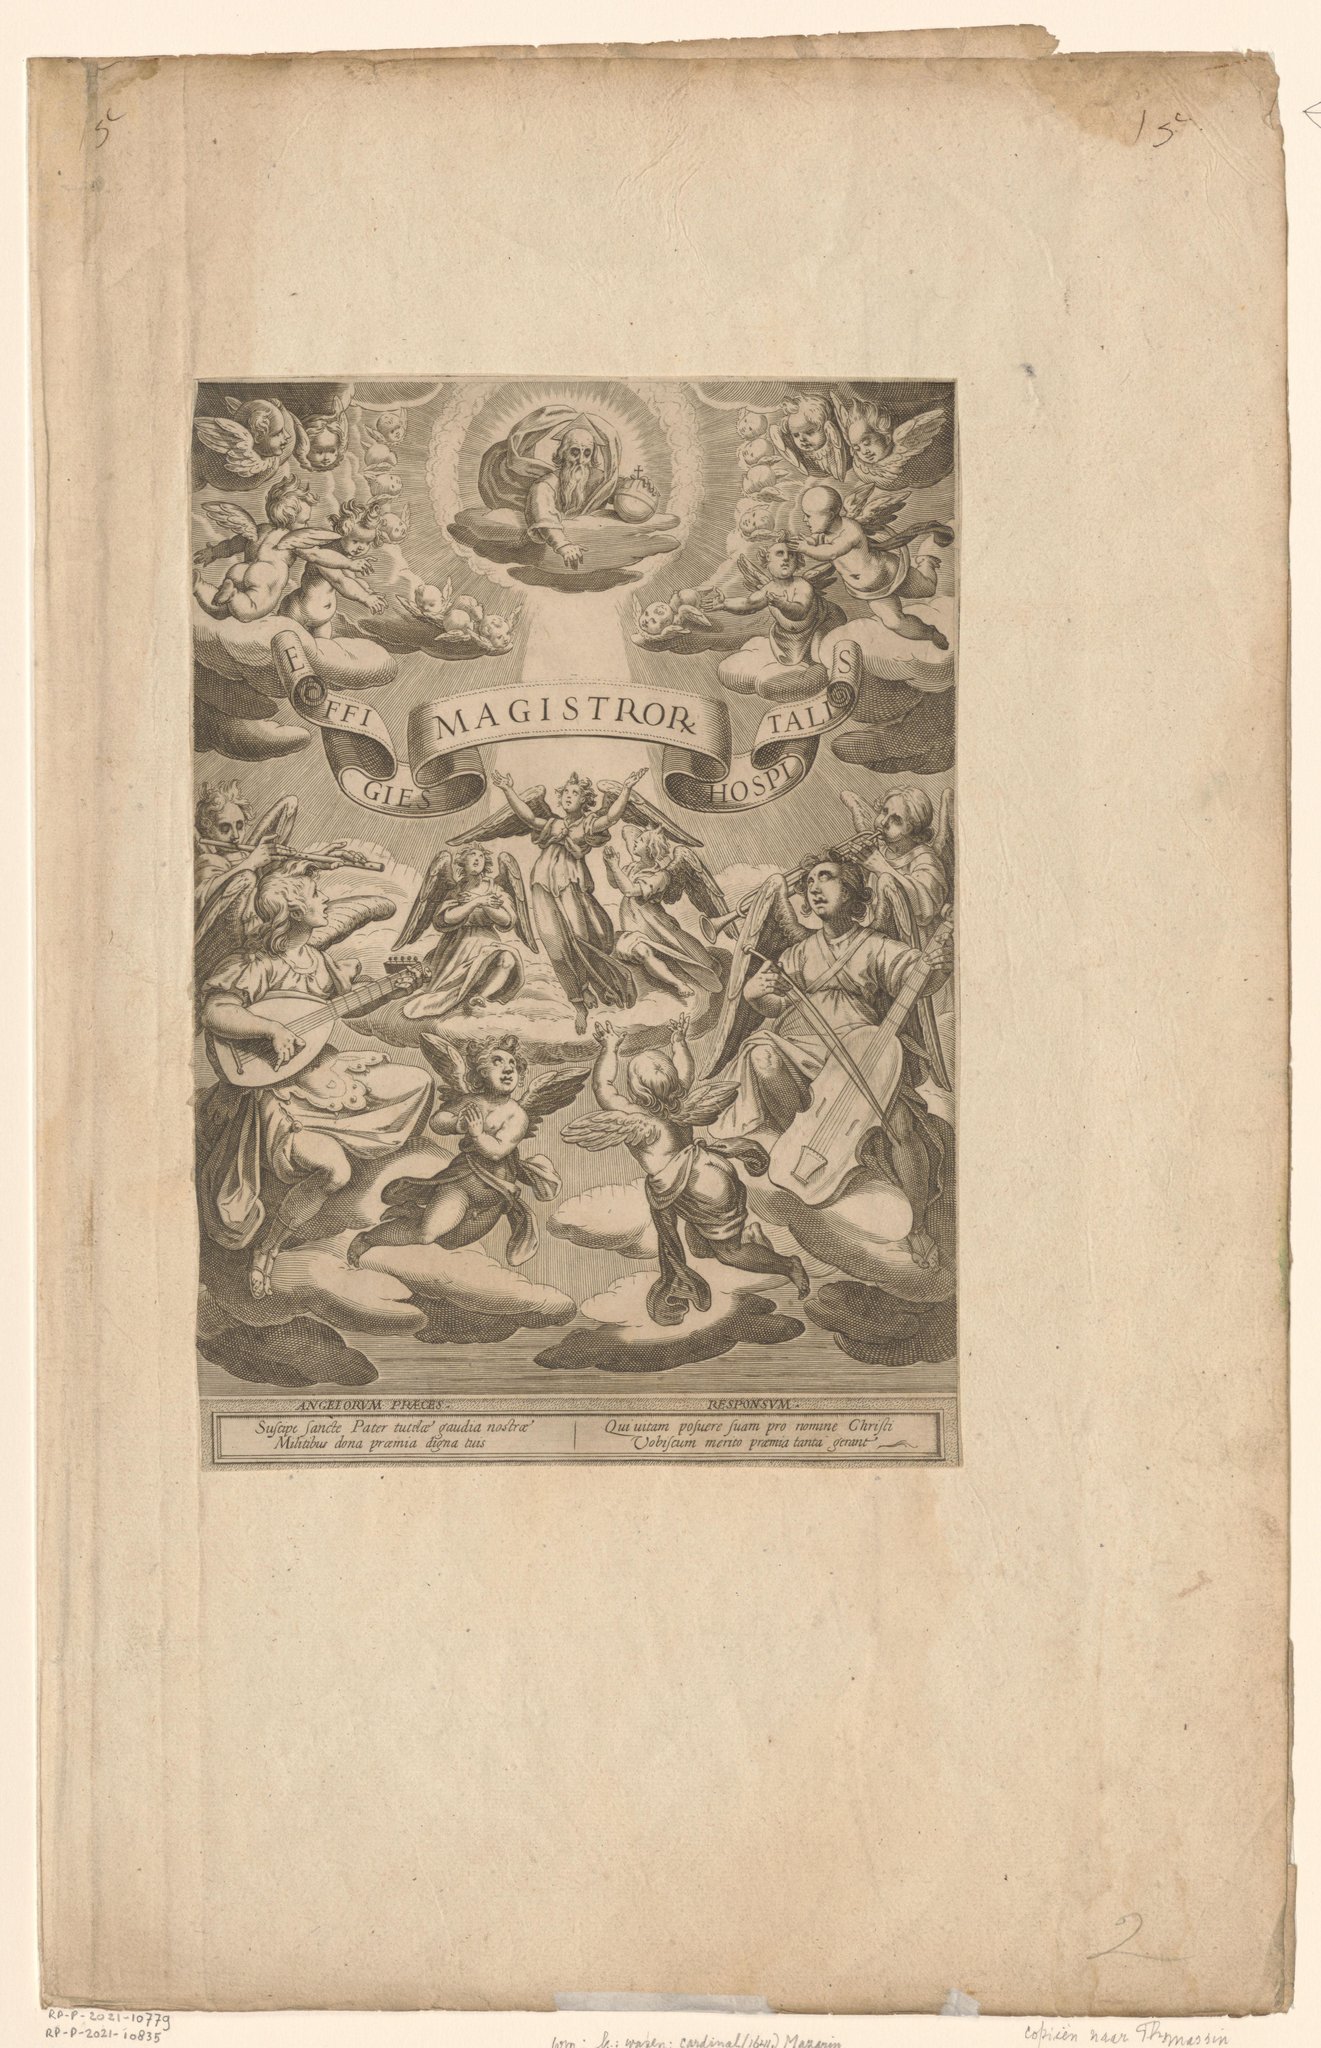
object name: print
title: Hemels concert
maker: philippe thomassin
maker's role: print maker, publisher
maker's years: 1562-1622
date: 1588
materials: paper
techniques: engraving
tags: angels singing, making music, god the father, angels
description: Musicerende engelen en engelen zonder instrumenten op wolken. Allen kijken op naar God de Vader.